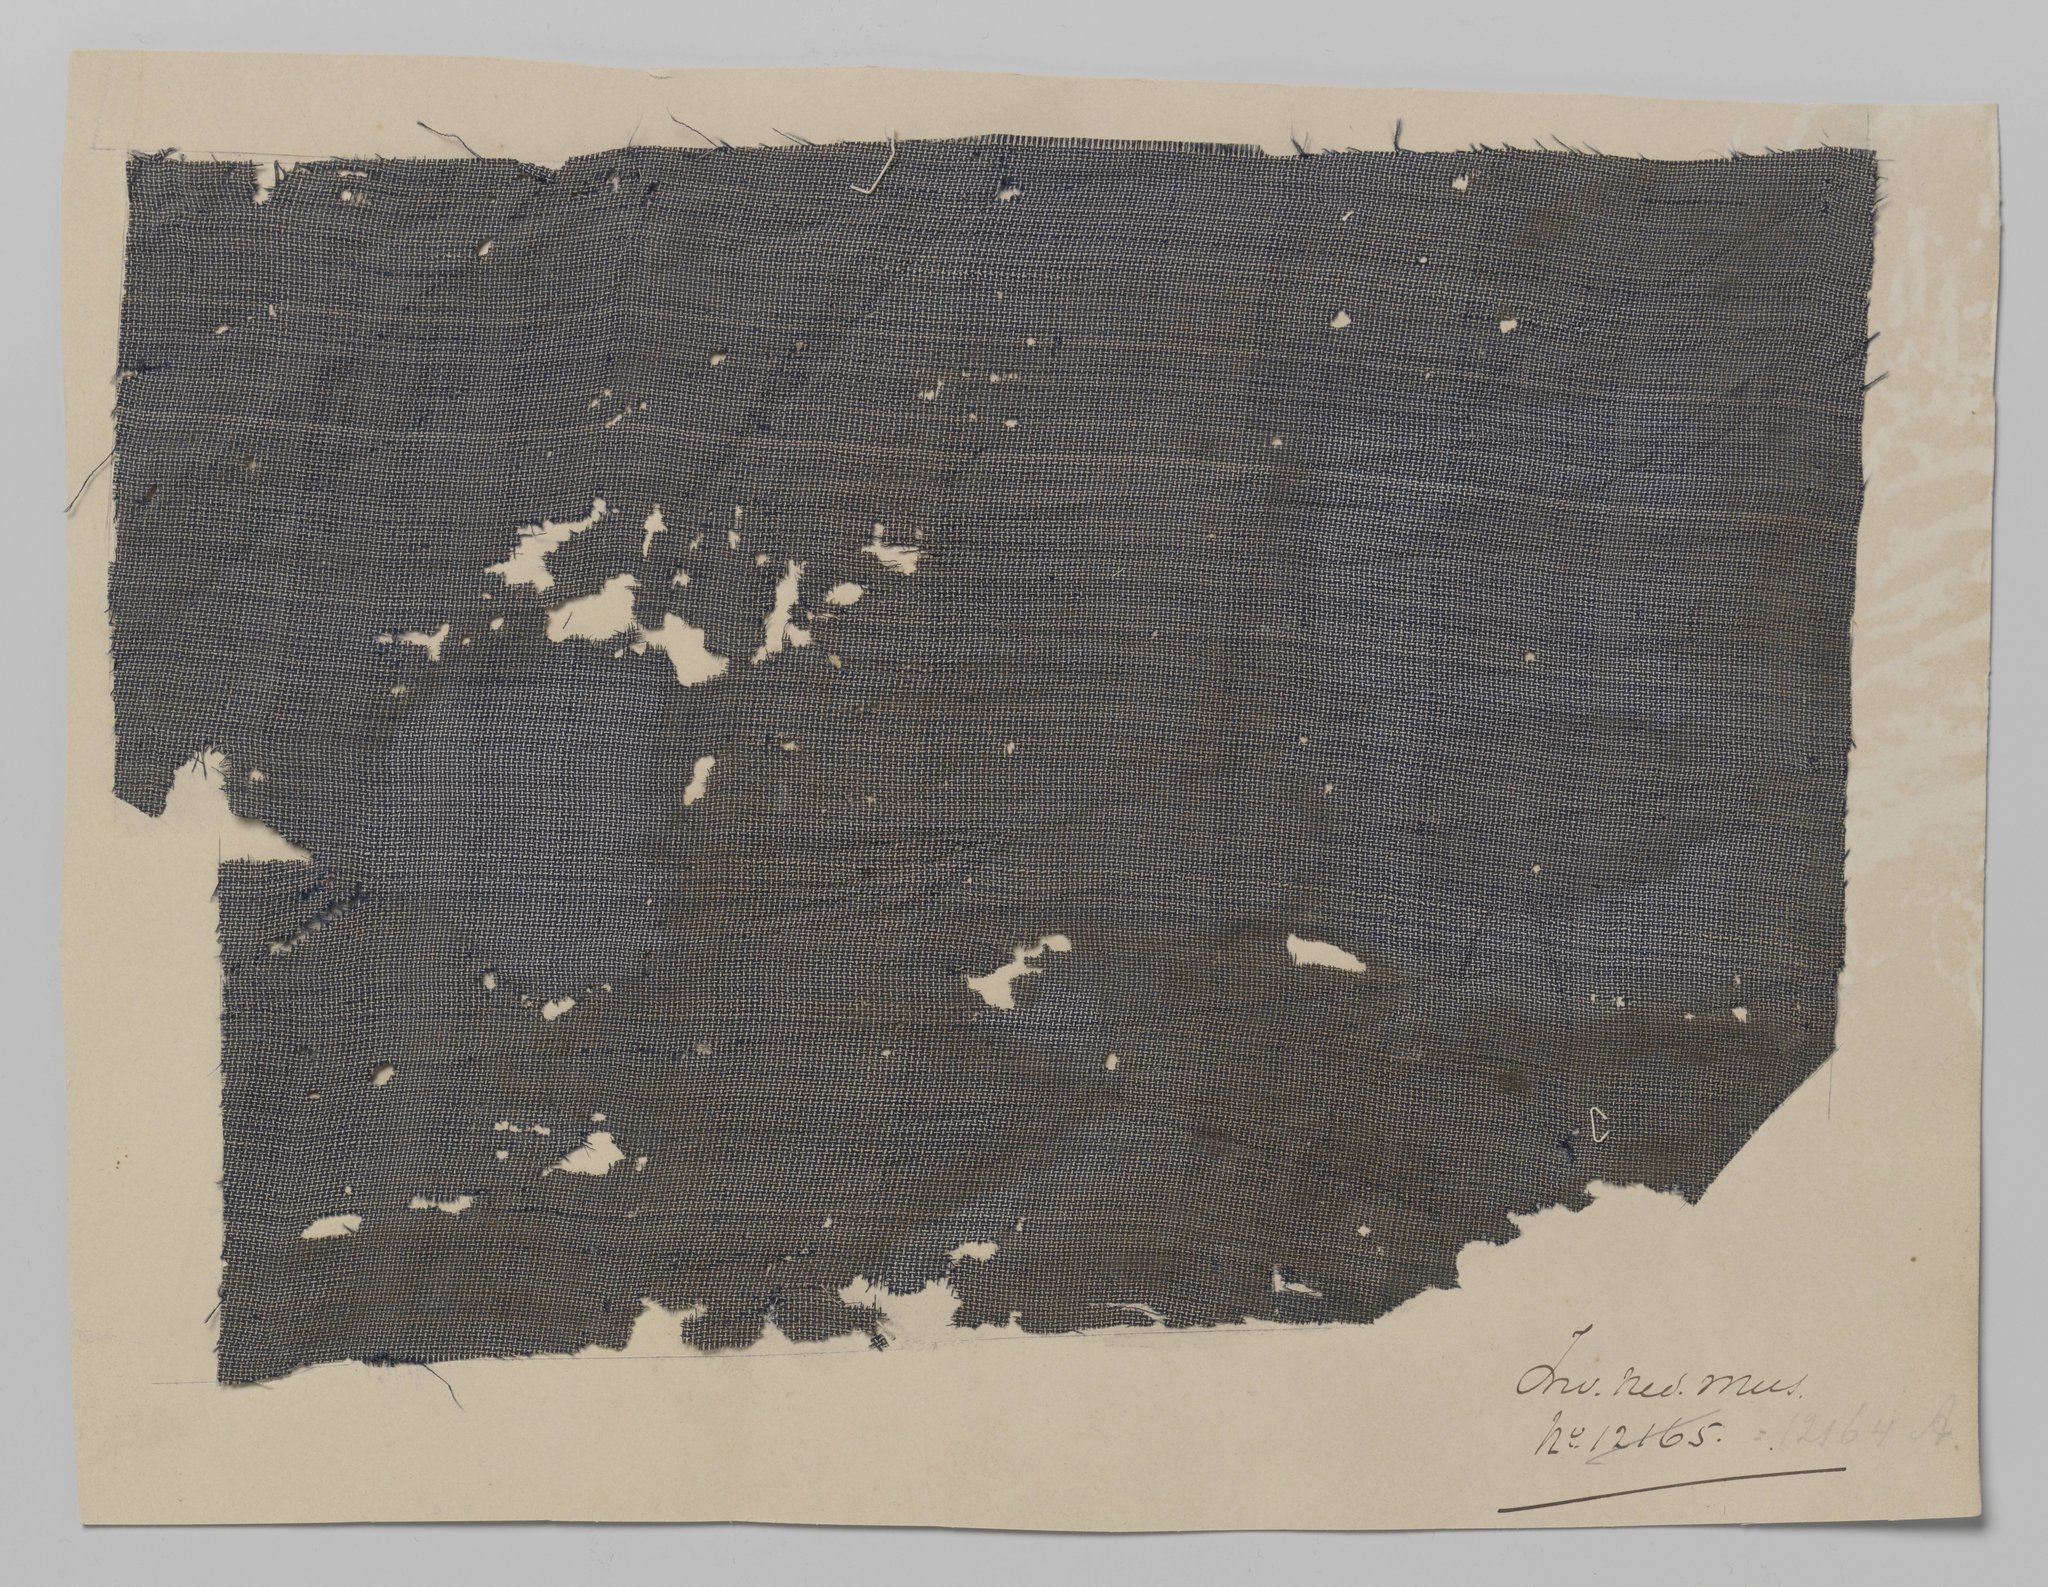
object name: silk textile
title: Zijdeweefsel in blauw en wit schijnpatroon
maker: Anonymous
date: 600-699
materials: silk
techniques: weave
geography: egypt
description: Zijden weefselfragment in blauwe en witte effenbinding met schijnpatroon.